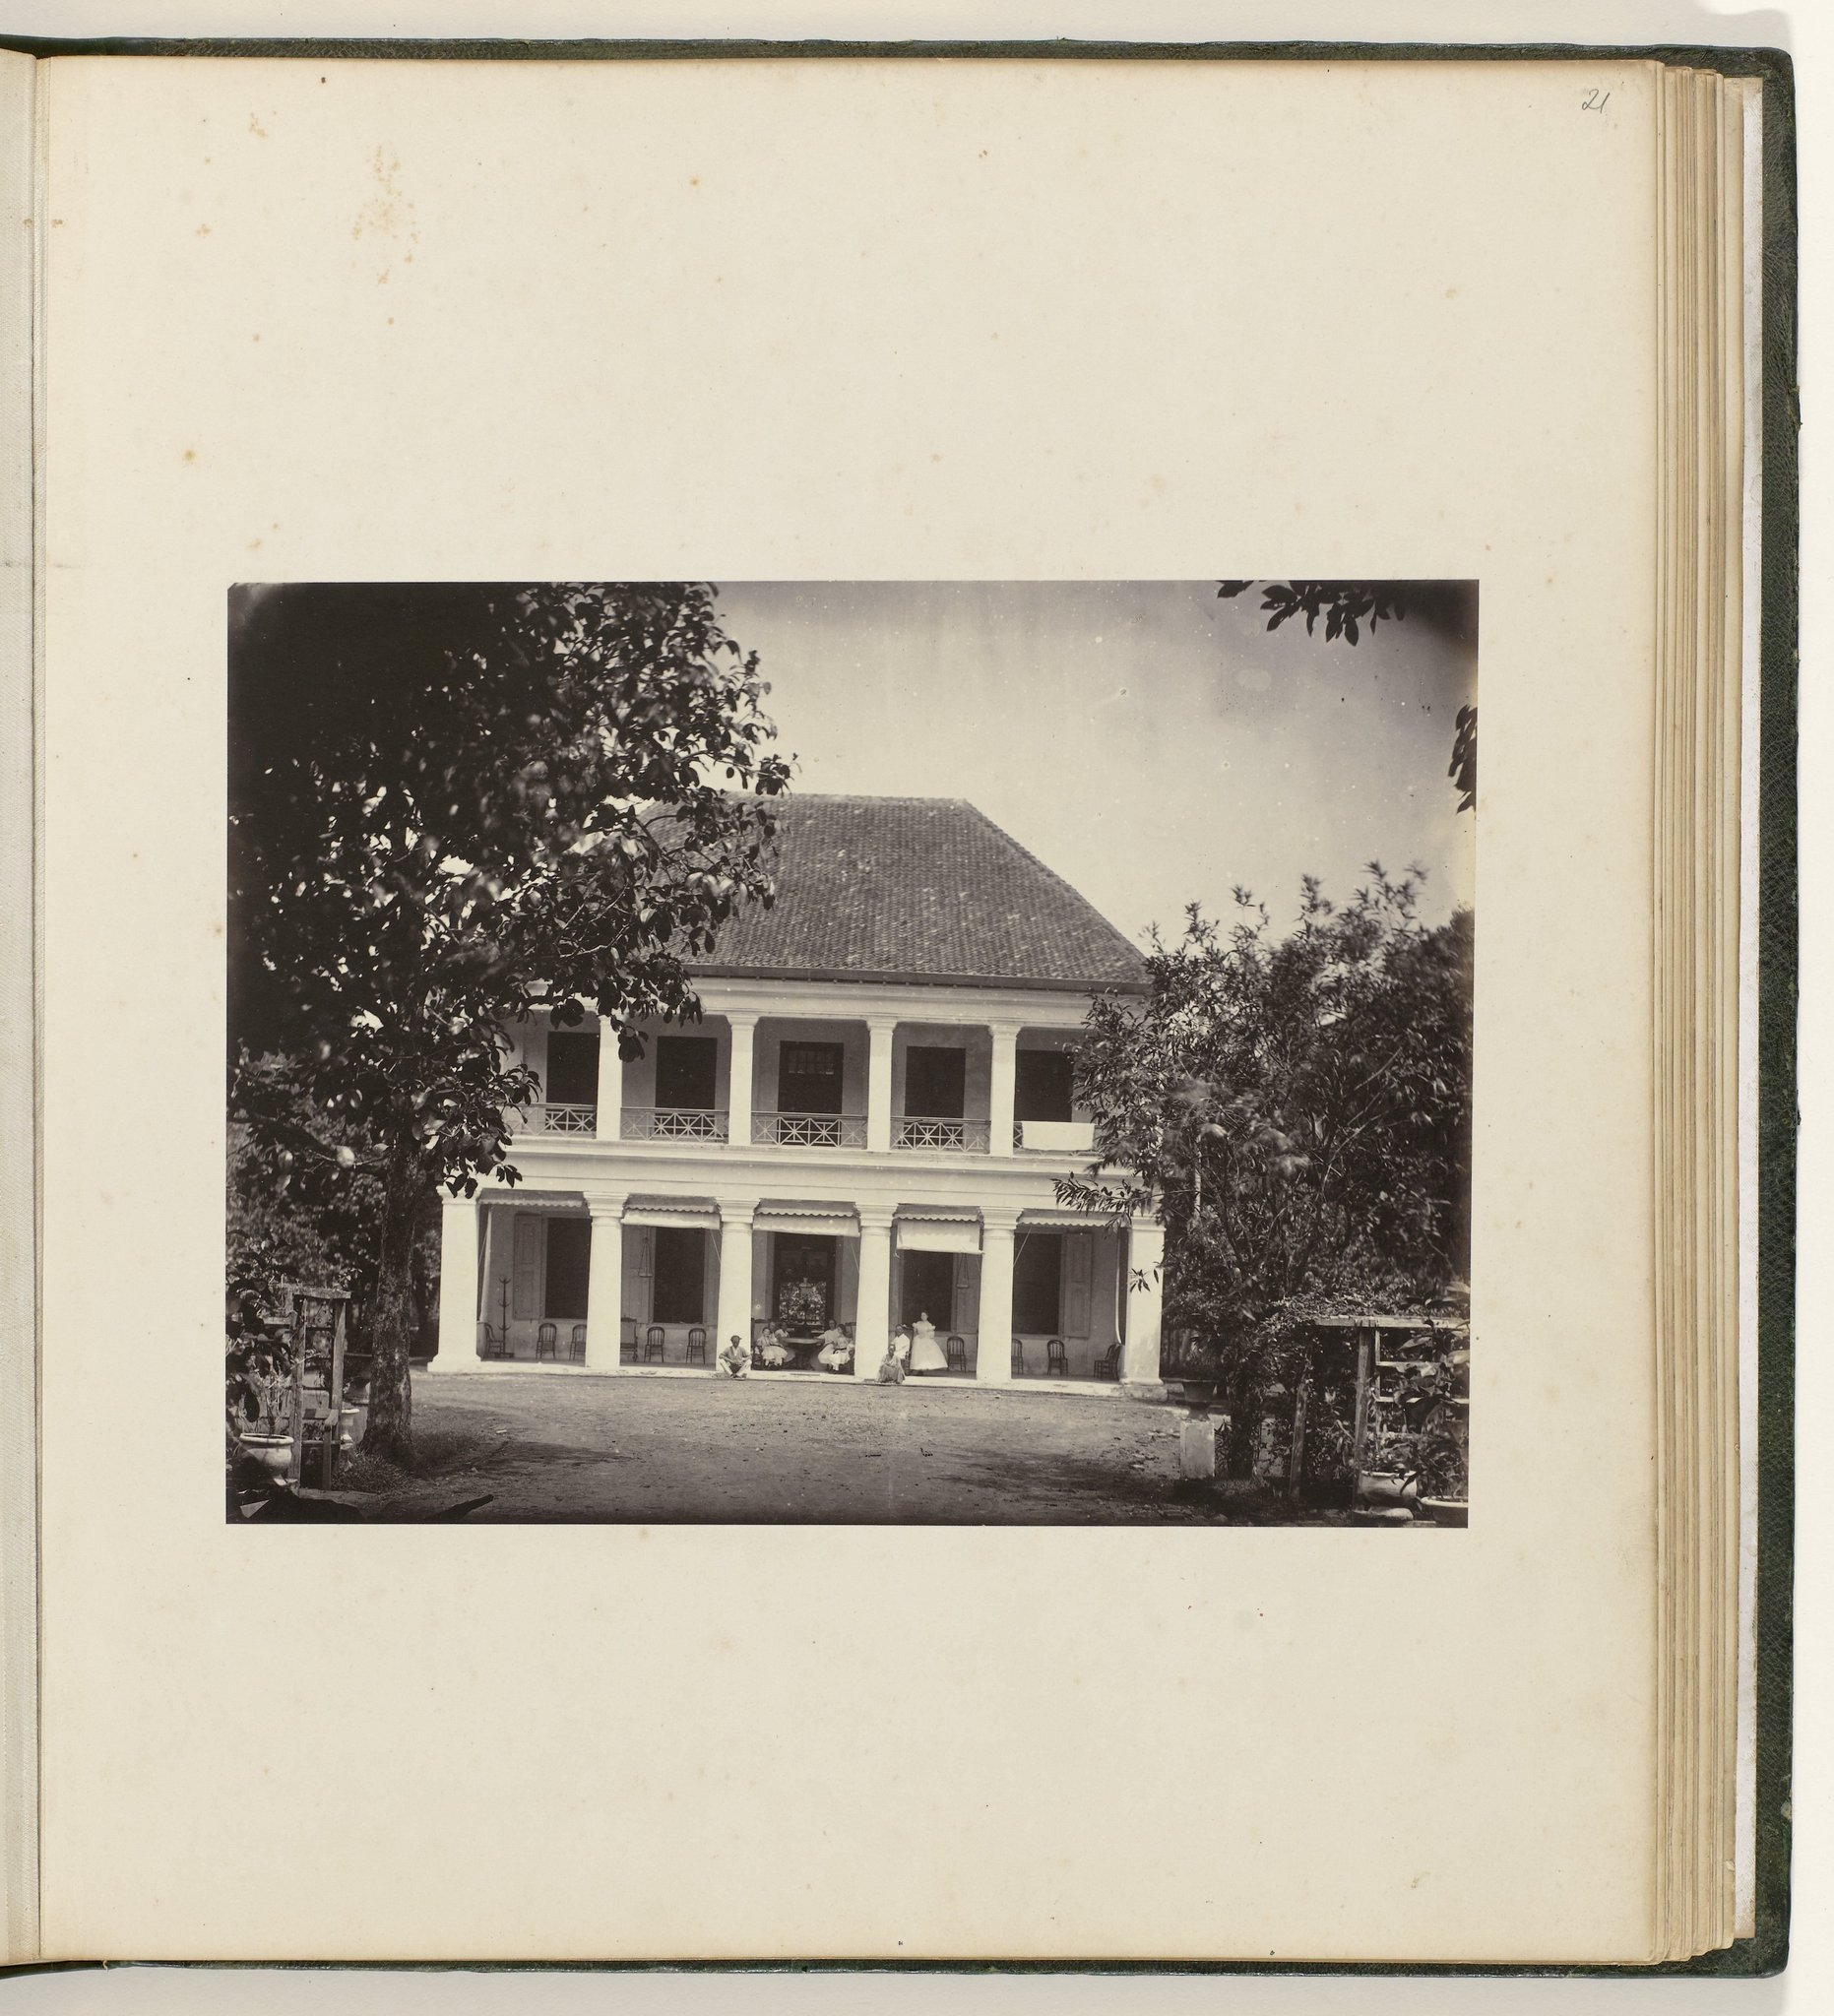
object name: photograph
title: Woonhuis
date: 1863-1866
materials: photographic support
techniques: albumen print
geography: batavia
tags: detached house in city, batavia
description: Gezicht op een woonhuis met zuilen op twee verdiepingen, waarschijnlijk te Batavia. De bewoners poseren op de veranda van het huis. Onderdeel van het tweede groene fotoalbum met foto's van Java, uit het bezit van apotheker Specht-Grijp, die in 1865 vanuit Batavia naar Nederland terugkeerde.